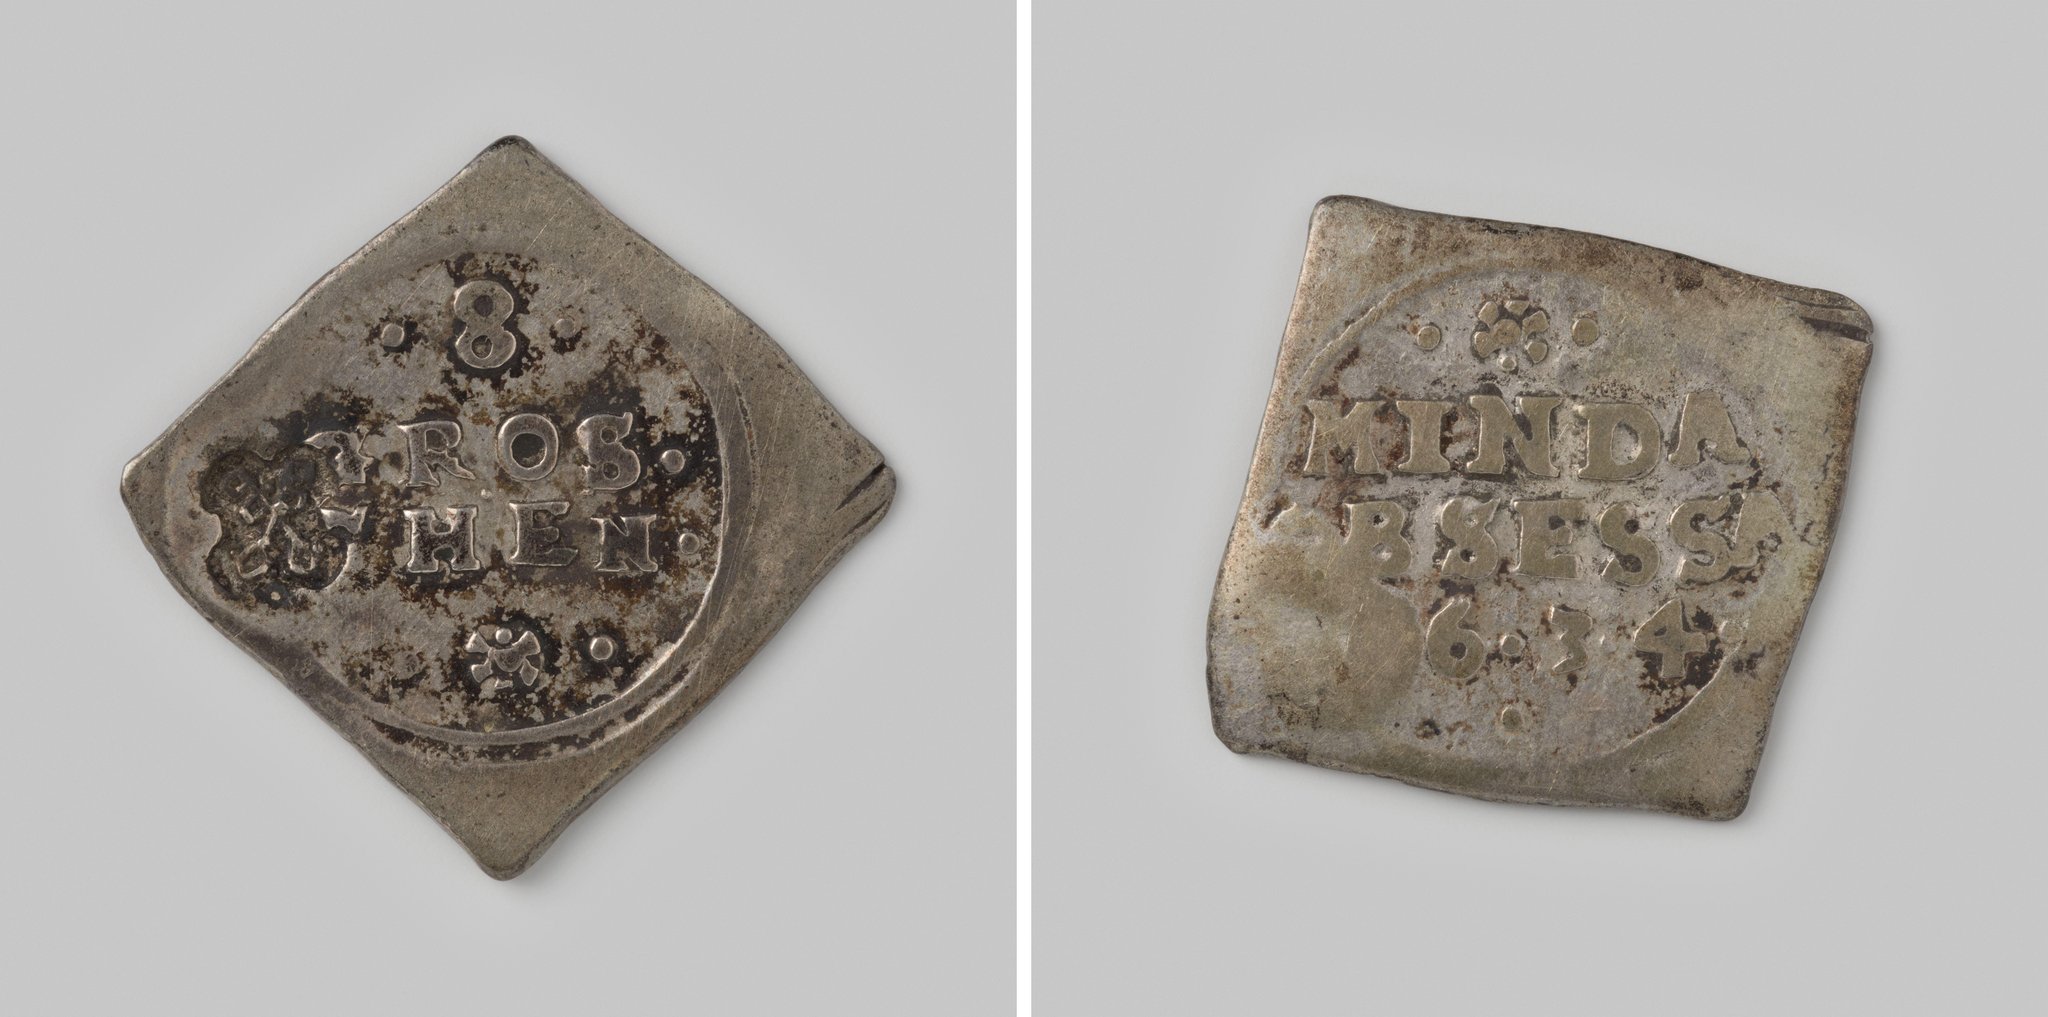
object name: acht mariëngroschen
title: Minden, Werstfalen, noodmunt van 8 Mariengroschen, 1634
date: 1634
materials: silver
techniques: striking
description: Zilveren vierkante noodmunt. Voorzijde: in twee regels opschrift: MINDA OBSESSA, waaronder jaartal. Keerzijde: in twee regels waarde-aanduiding met klop stadswapen: twee gekruiste sleutels.